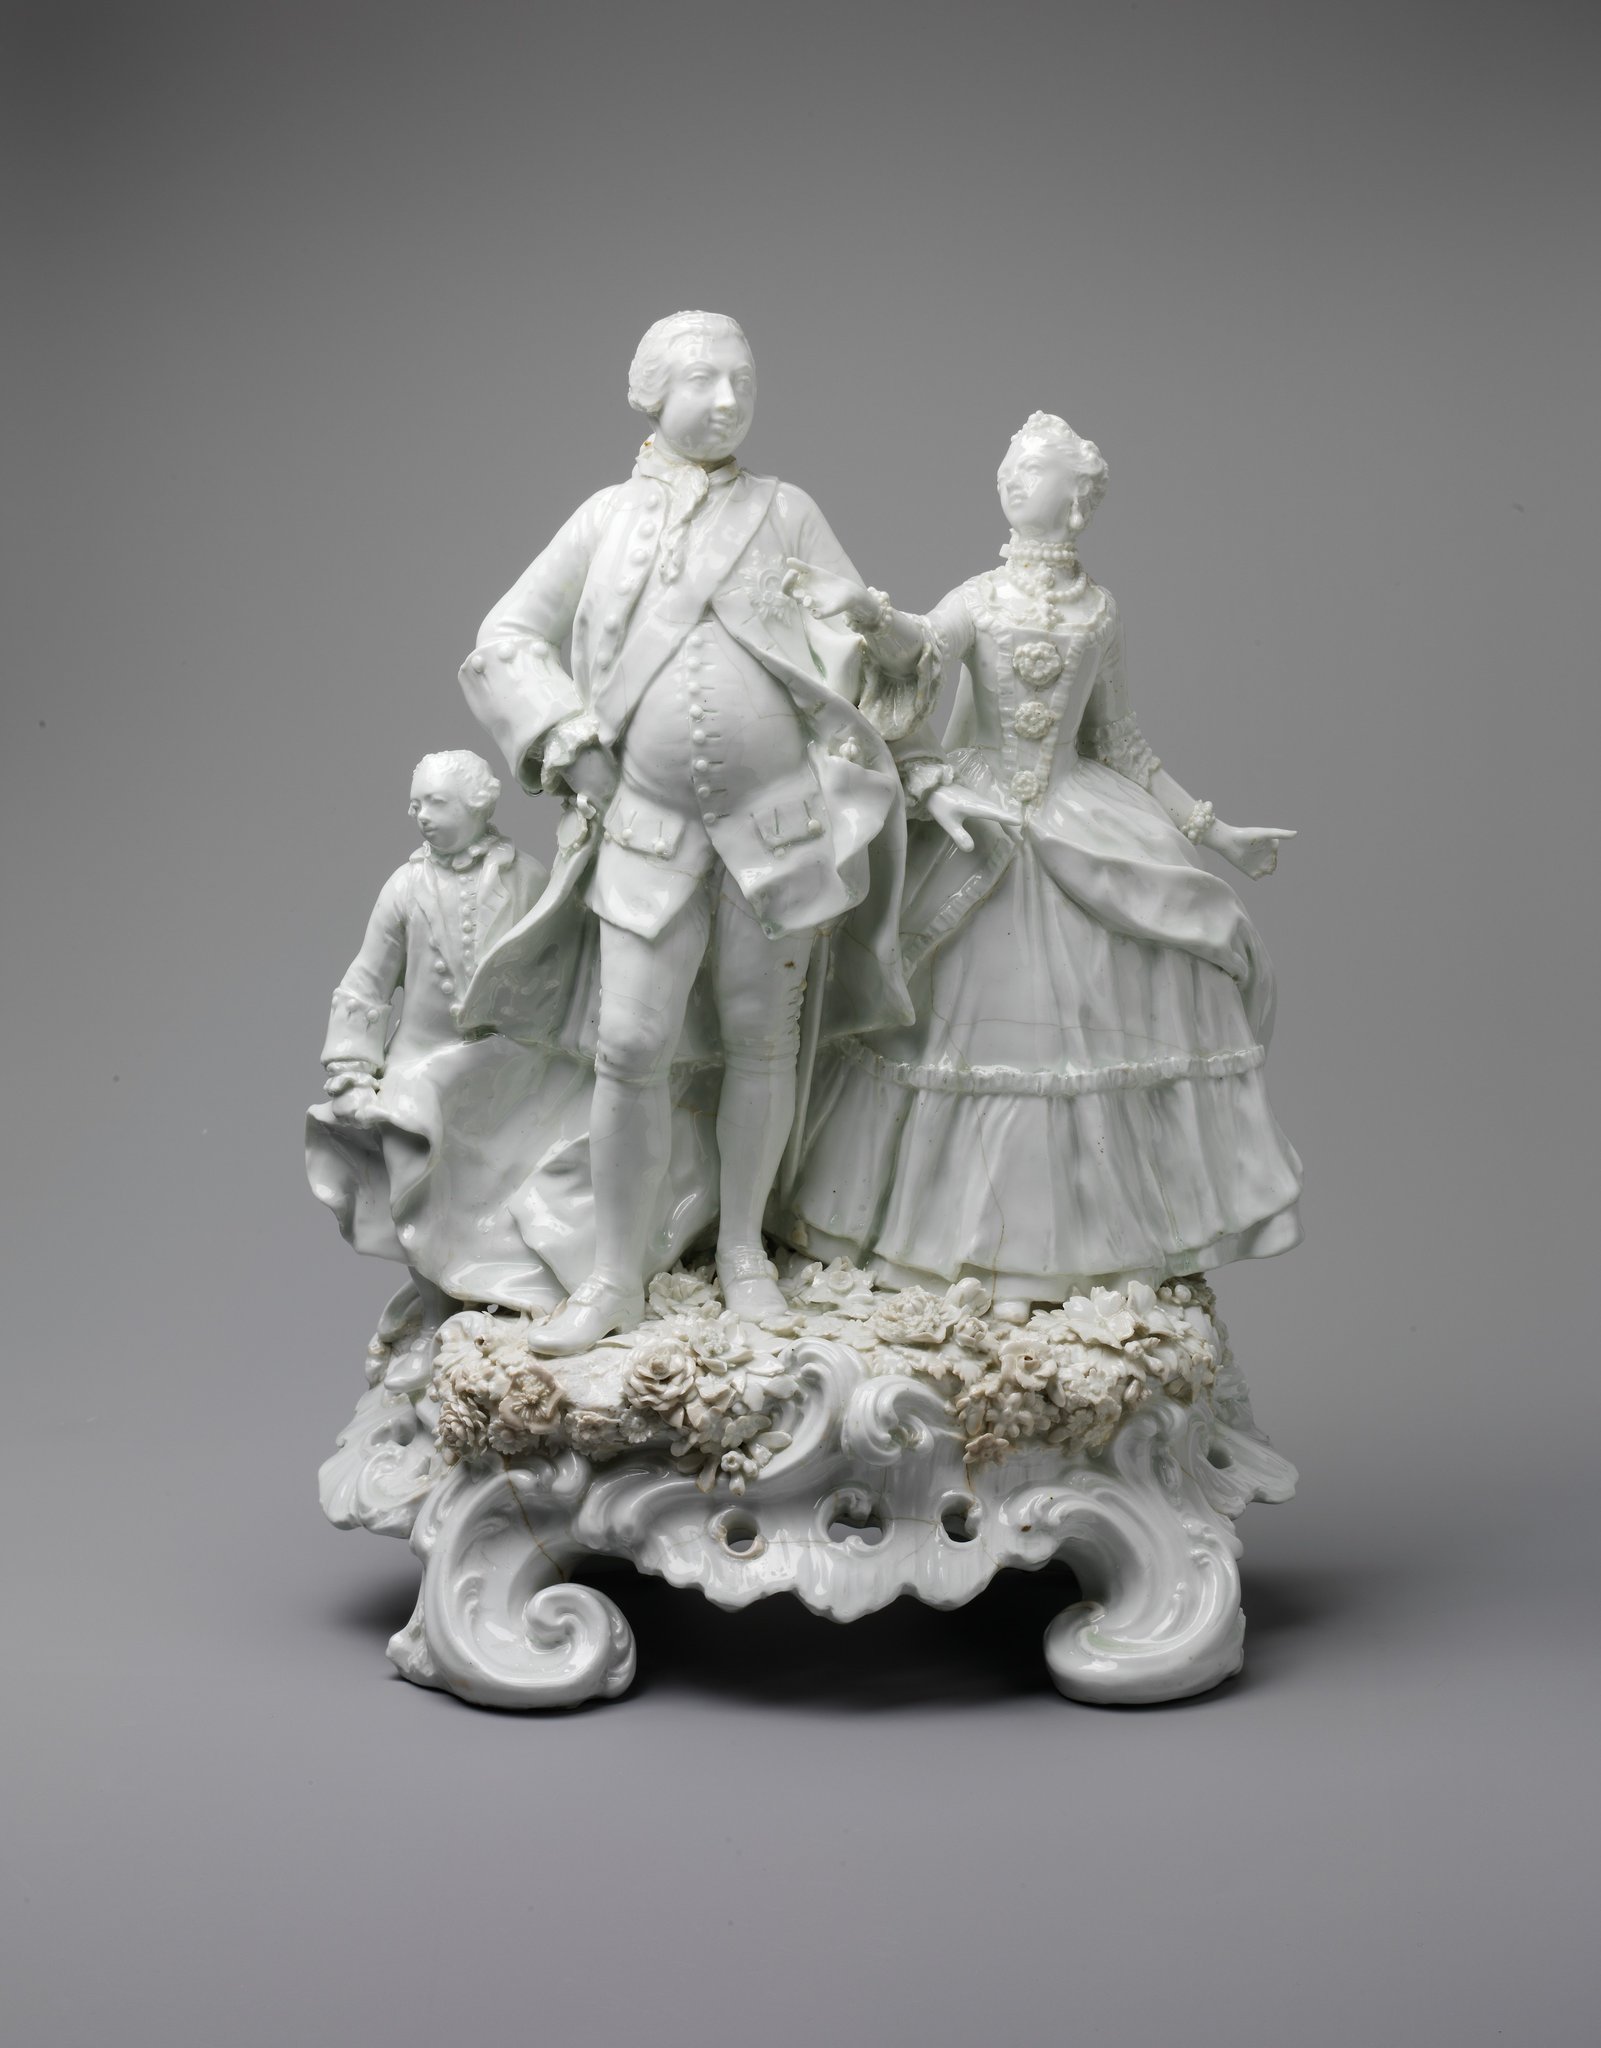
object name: group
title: The Royal Family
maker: chelsea porcelain manufactory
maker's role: factory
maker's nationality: british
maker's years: 1744-1784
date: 1761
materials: soft paste porcelain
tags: children,men,women,family